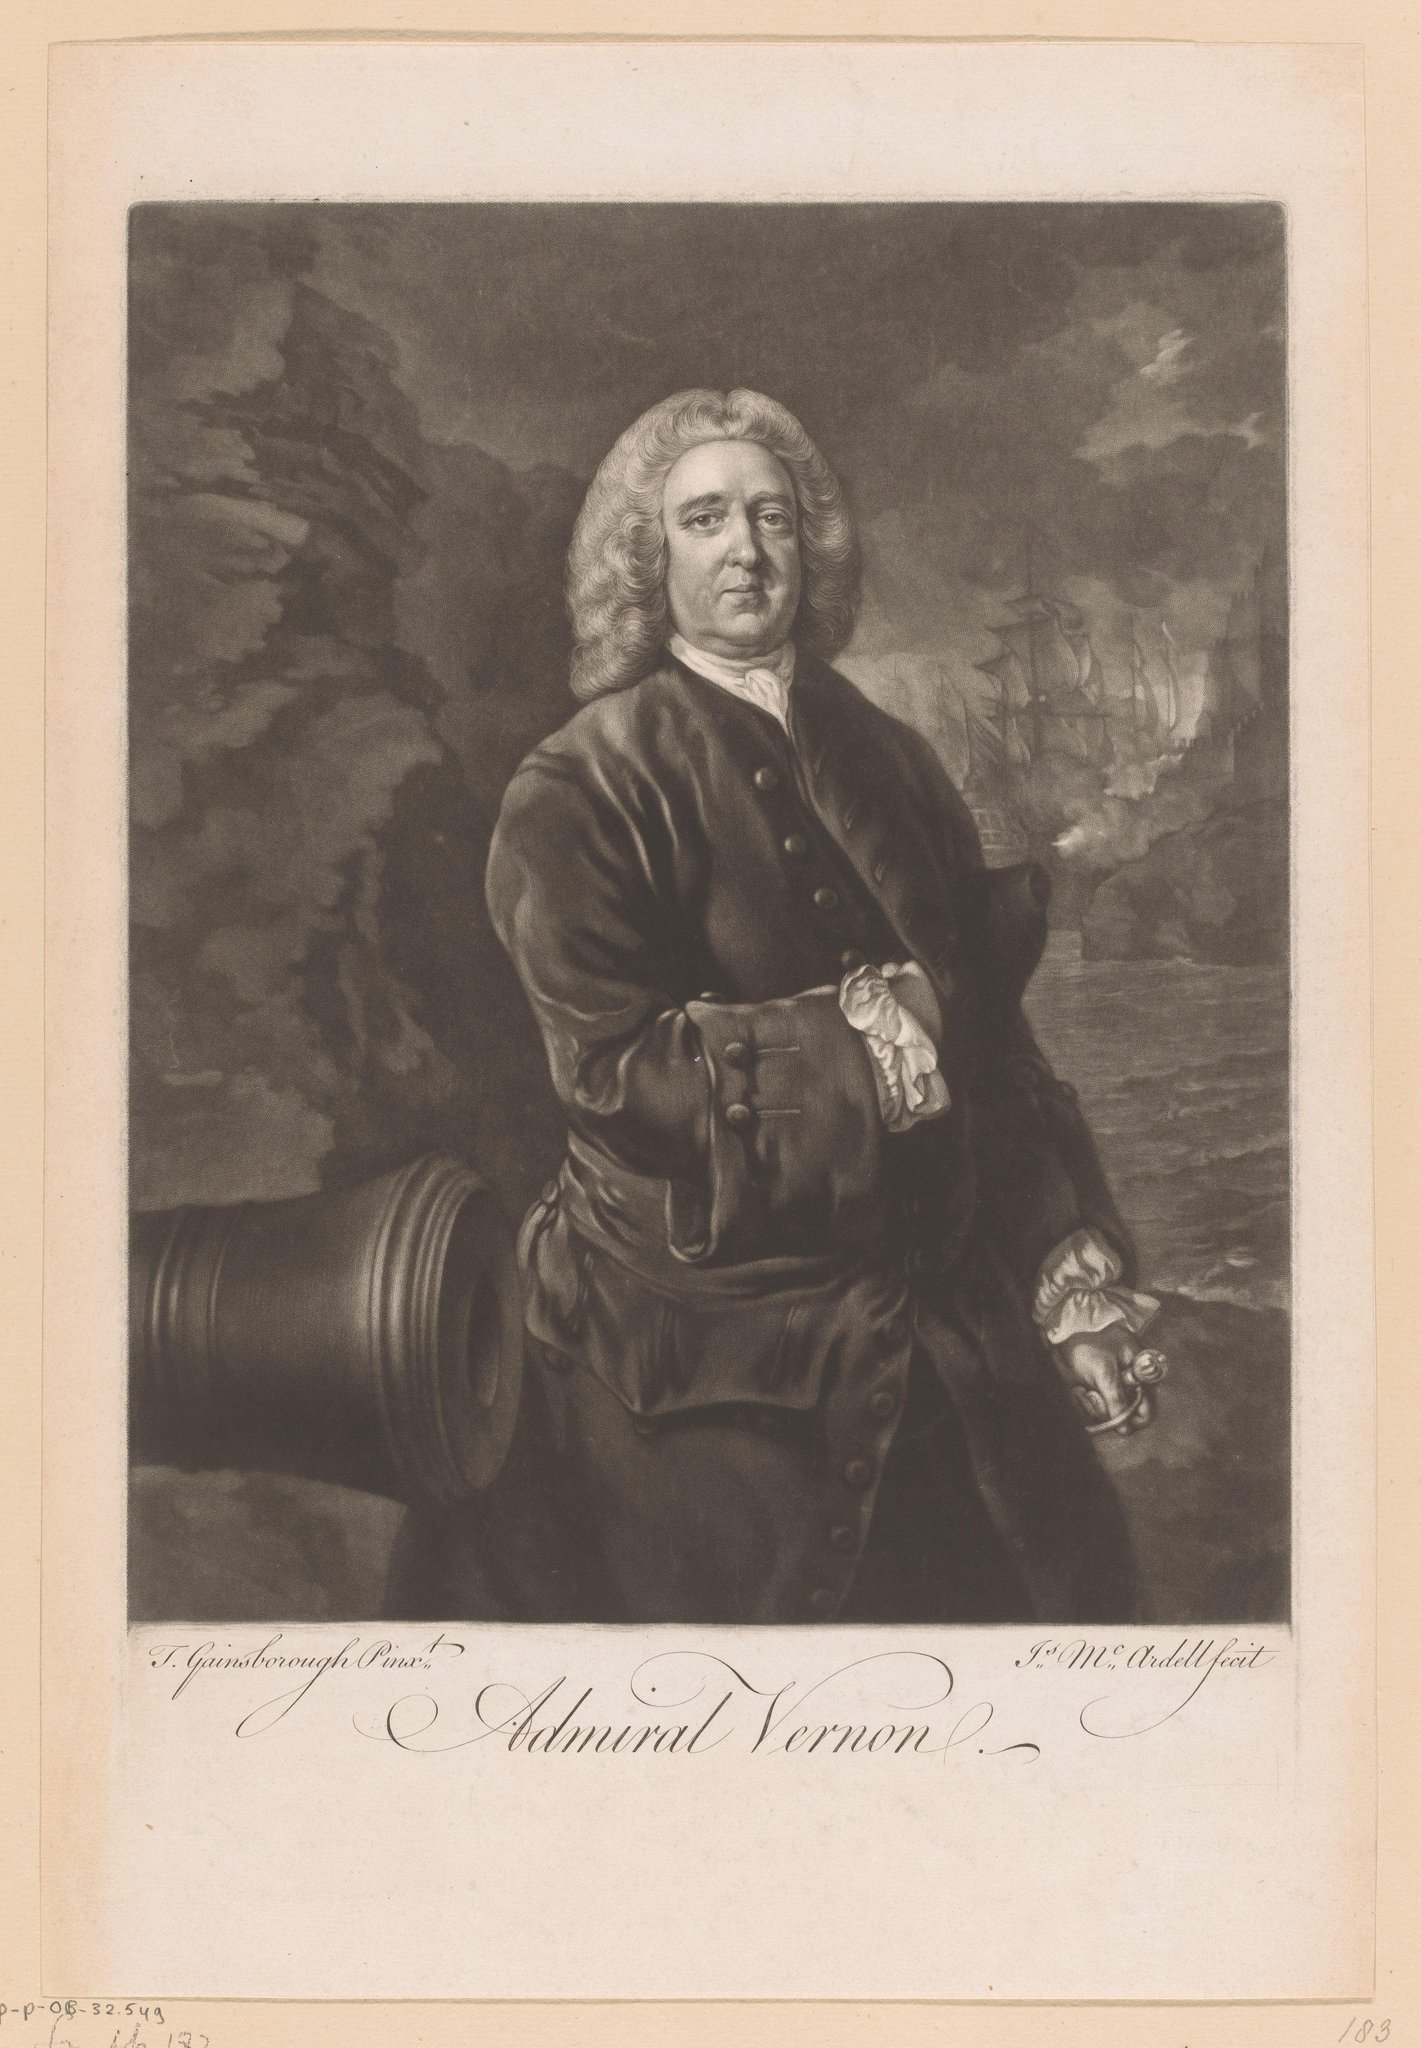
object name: print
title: Admiral Vernon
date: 1753-1765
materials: paper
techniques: mezzotint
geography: london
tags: battle (+ naval force), historical persons, firearms: cannon, commander-in-chief, admiral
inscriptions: collector's mark: Lugt 240